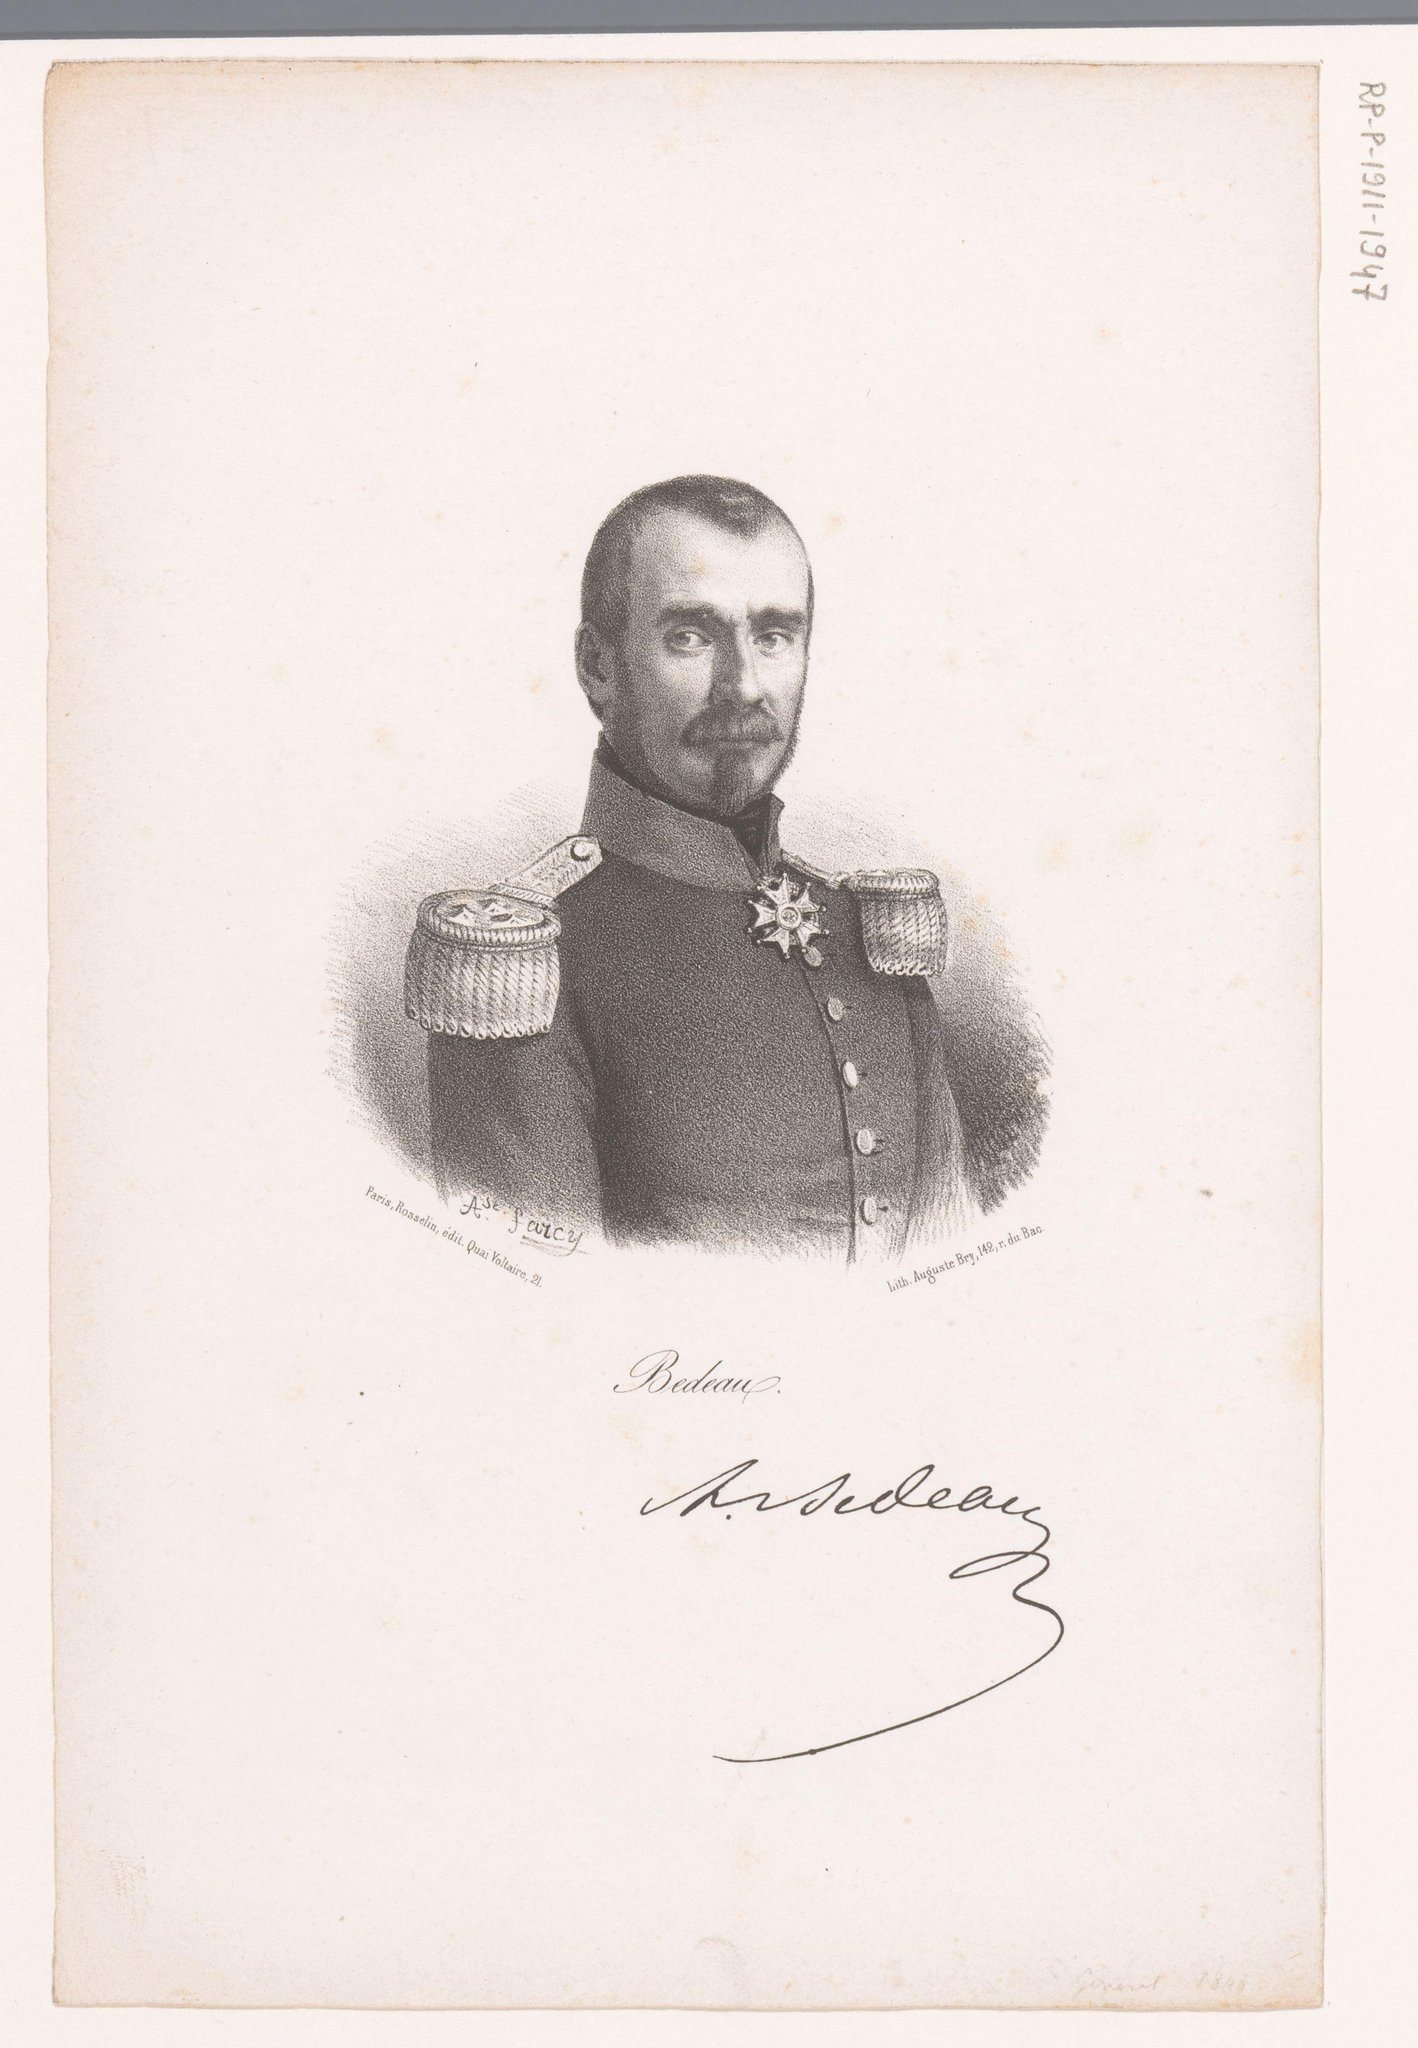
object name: print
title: Bedeau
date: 1849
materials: paper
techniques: lithograph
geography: paris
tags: historical persons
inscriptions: collector's mark: Lugt 2228a